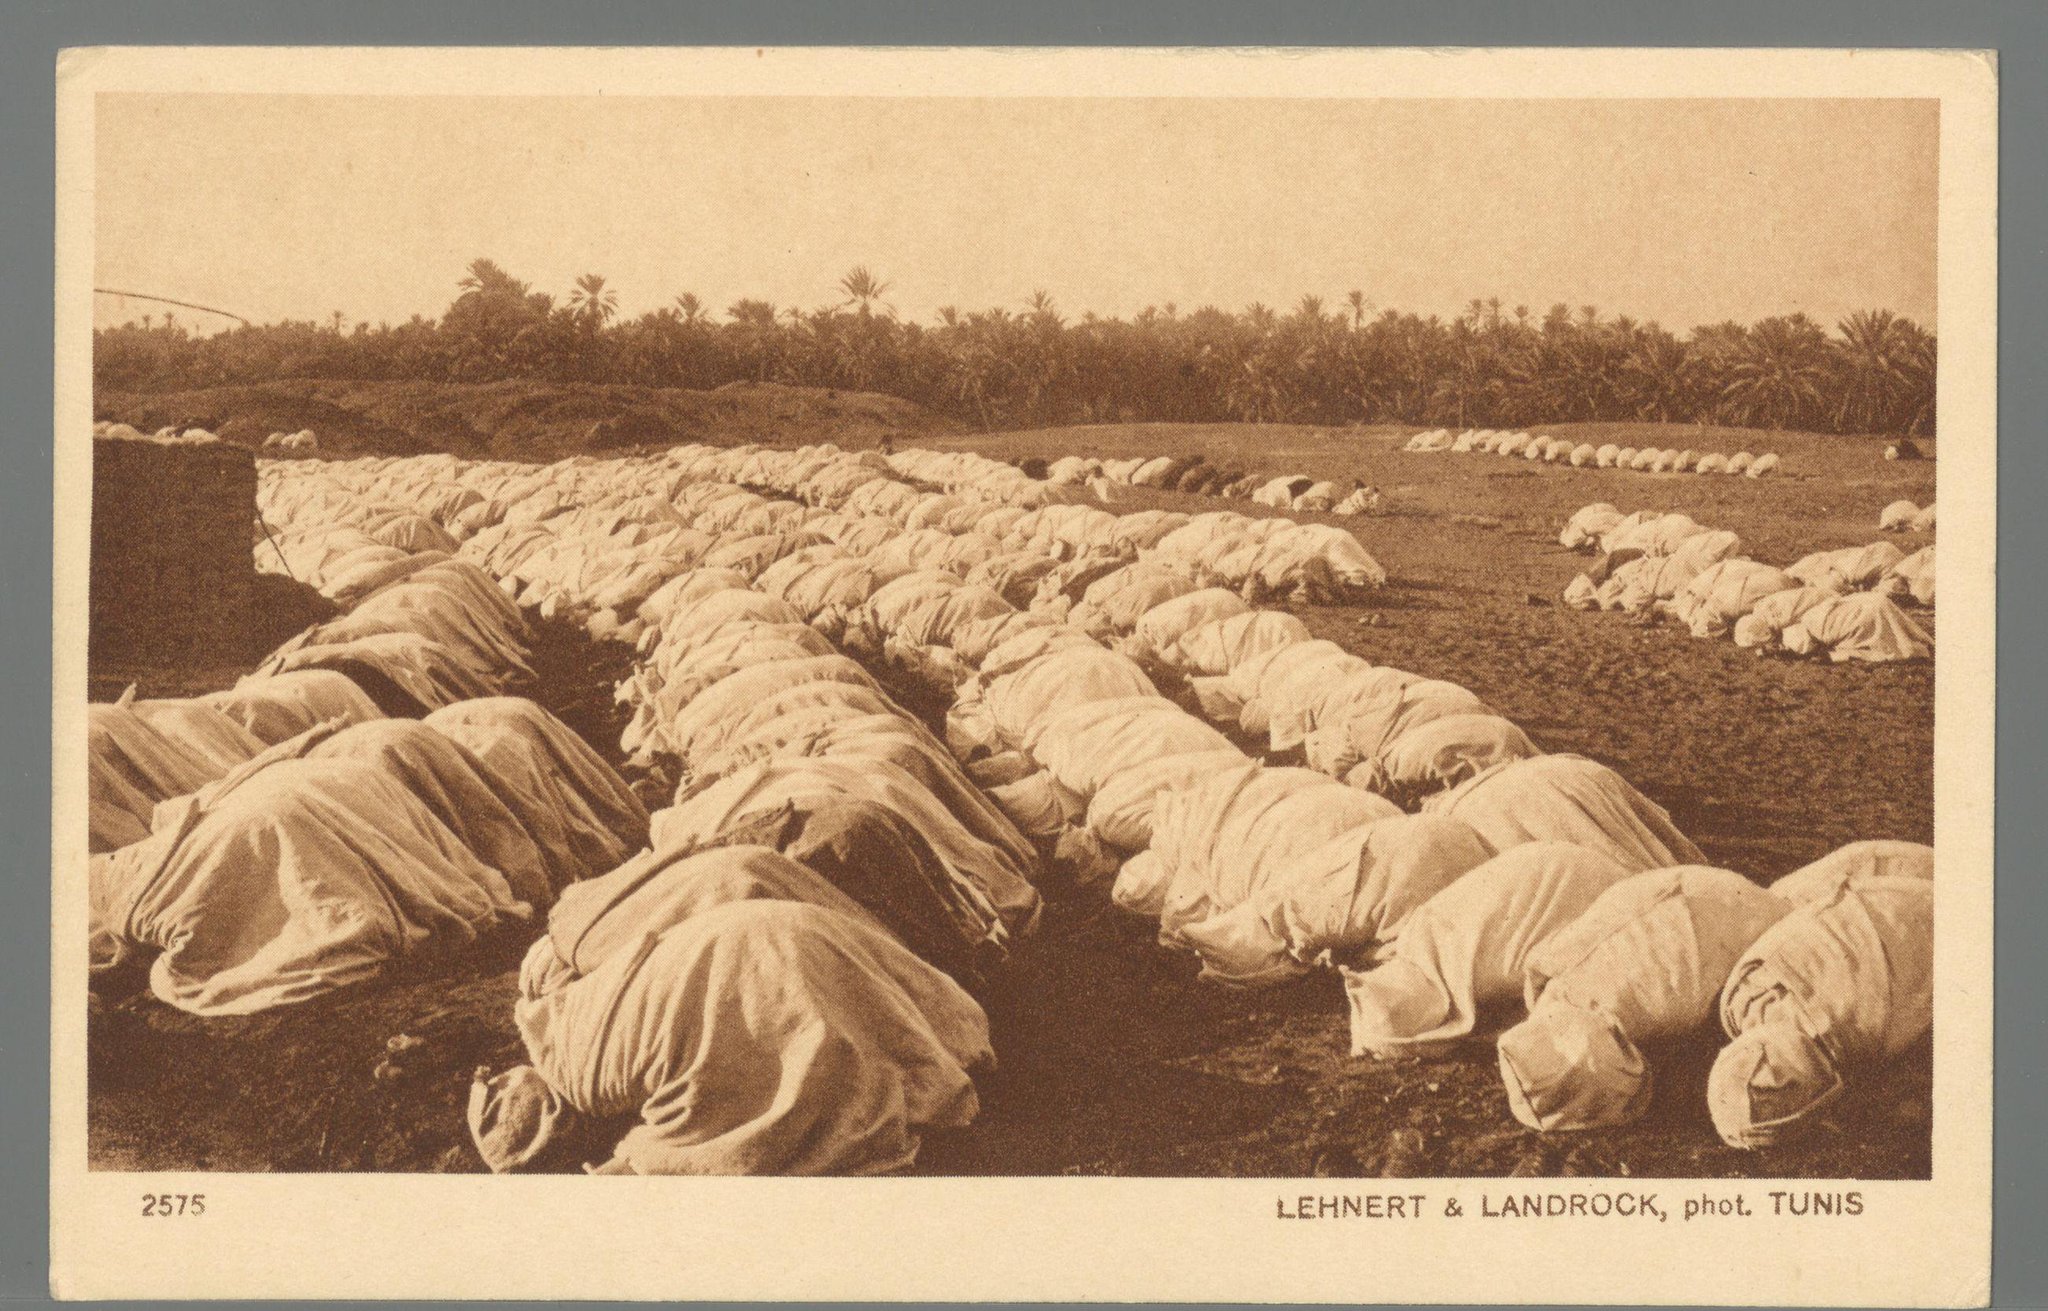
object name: ansichtkaart, prentbriefkaart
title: Paysages d'orient. Serie VII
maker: Anonymous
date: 1903-1930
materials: cardboard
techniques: rotogravure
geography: tunis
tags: desert, prayer ~ islam, mohammedanism